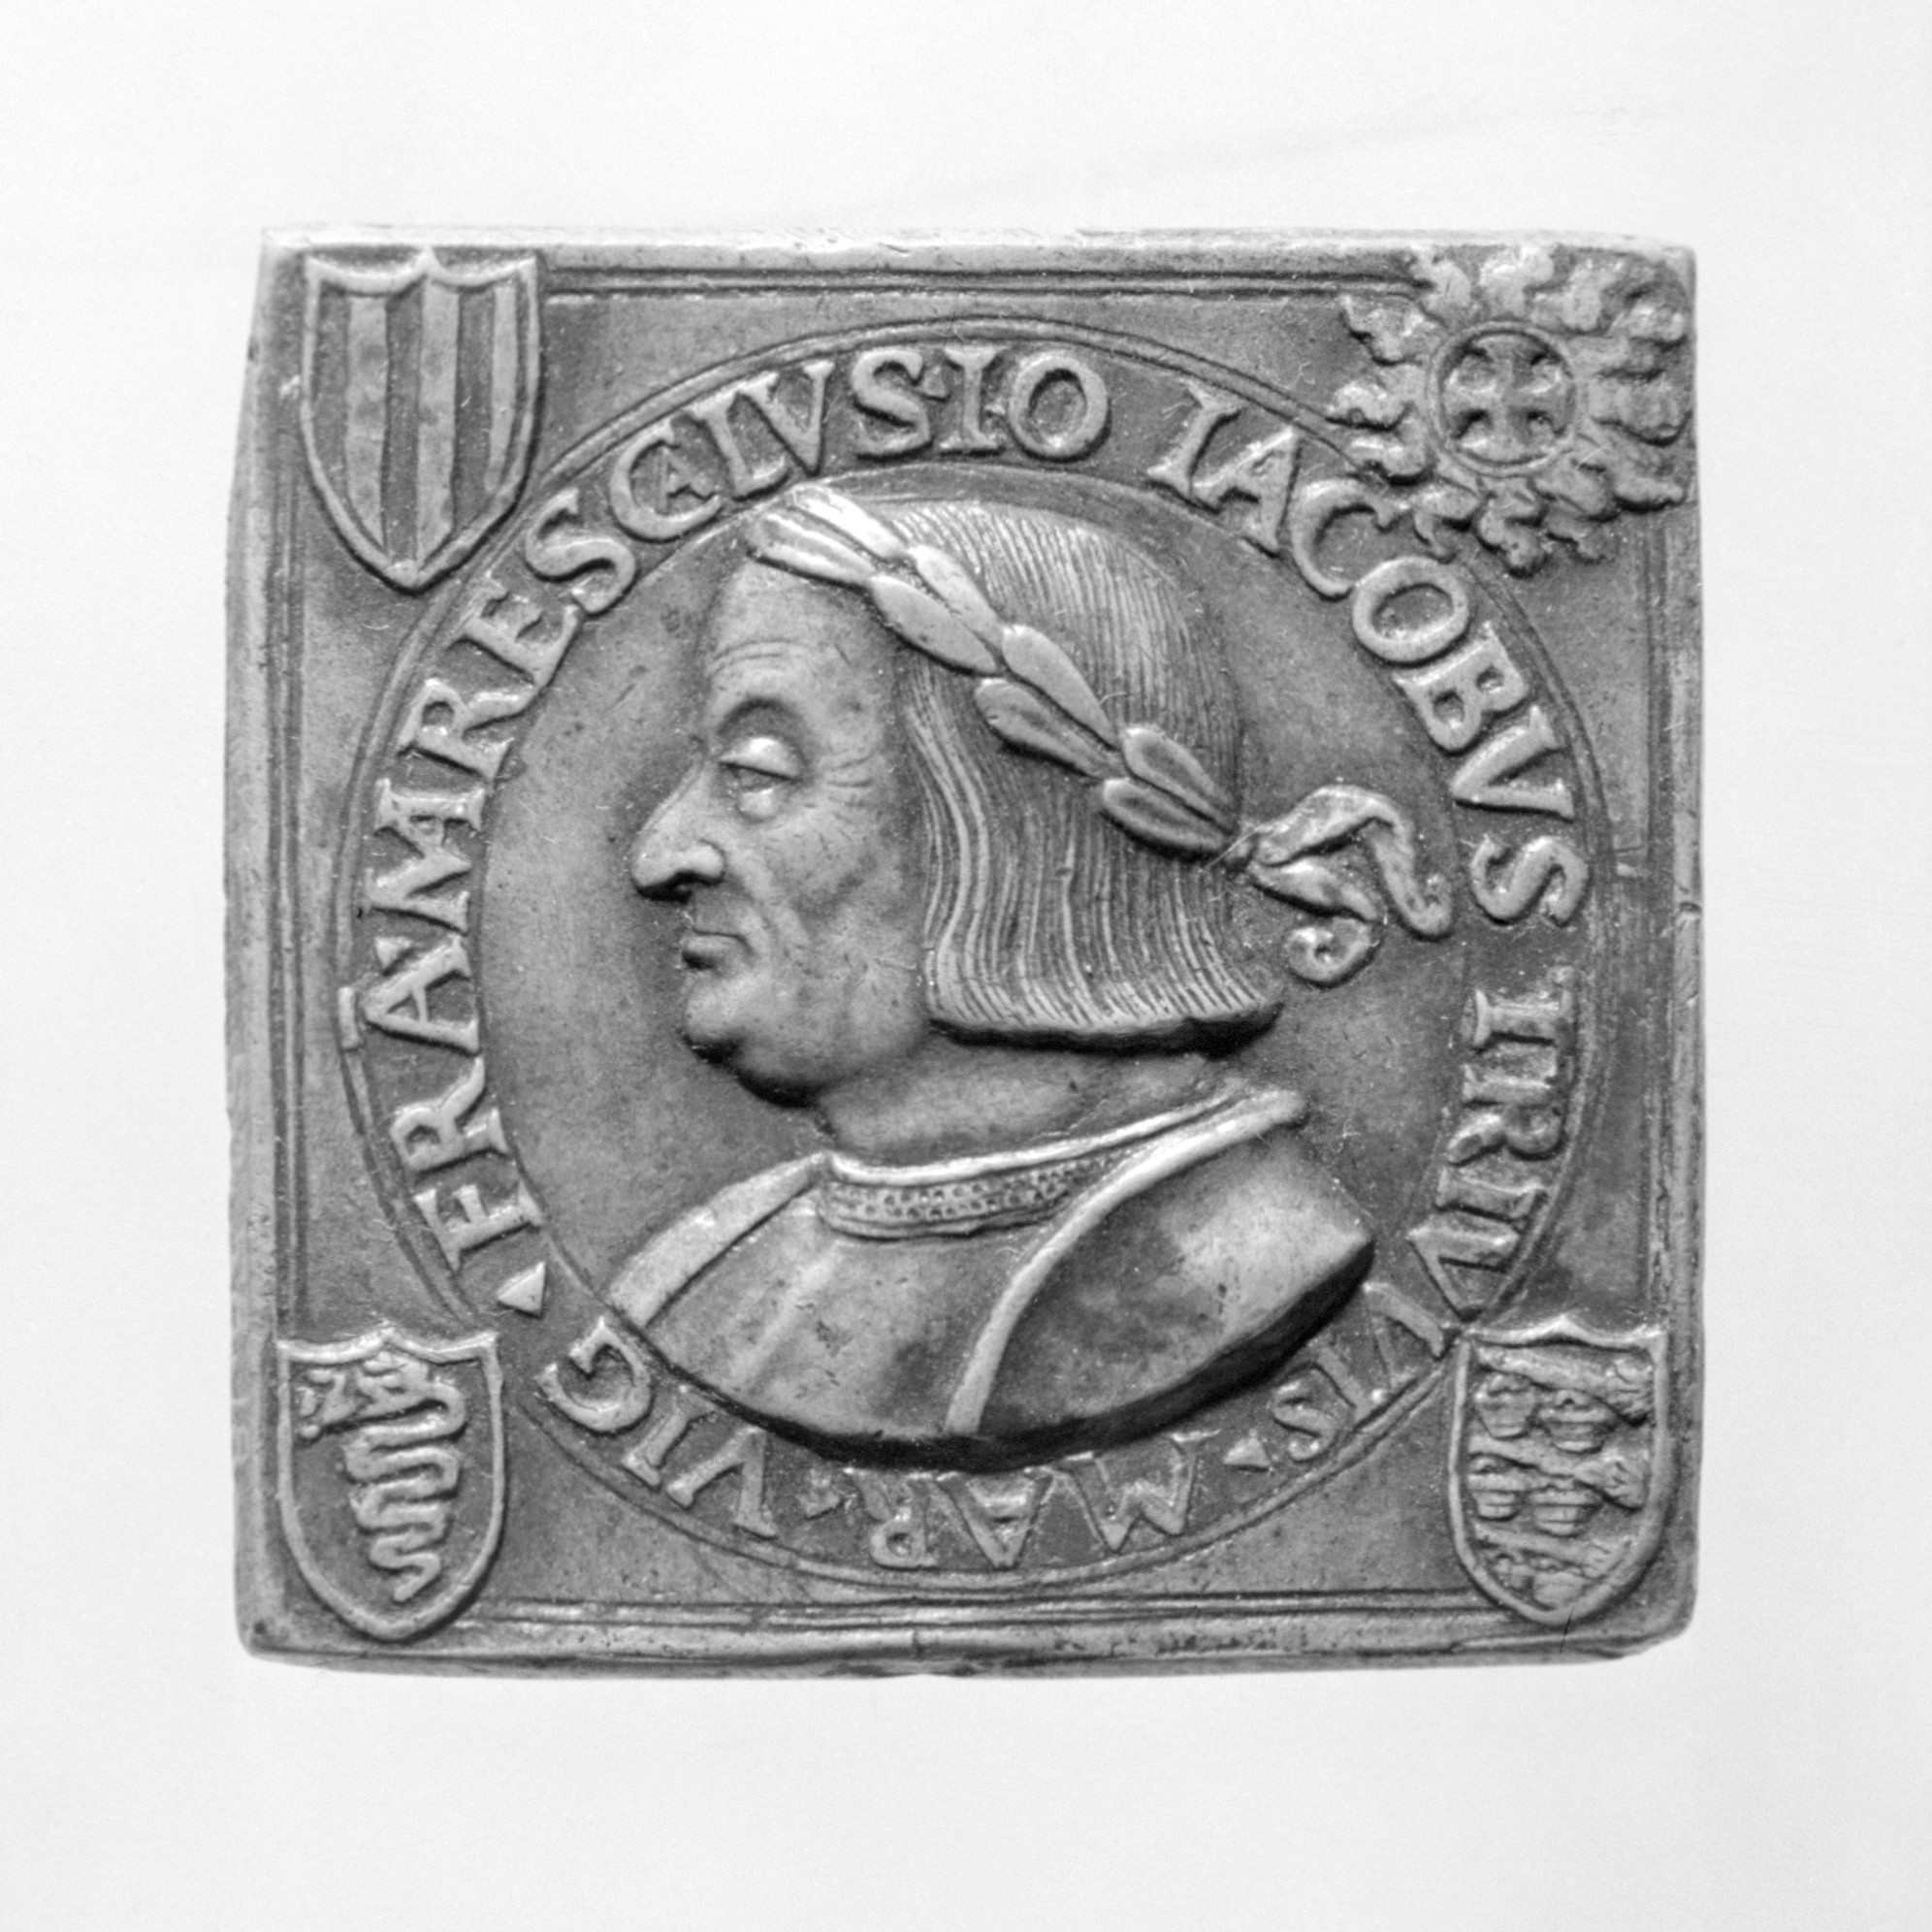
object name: medal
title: Giangiacomo Trivulzio of Milan, Marquis of Vigevano (1448–1518)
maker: caradosso (cristoforo caradosso foppa)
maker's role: artist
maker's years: 1470-1527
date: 1499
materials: bronze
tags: men,profiles